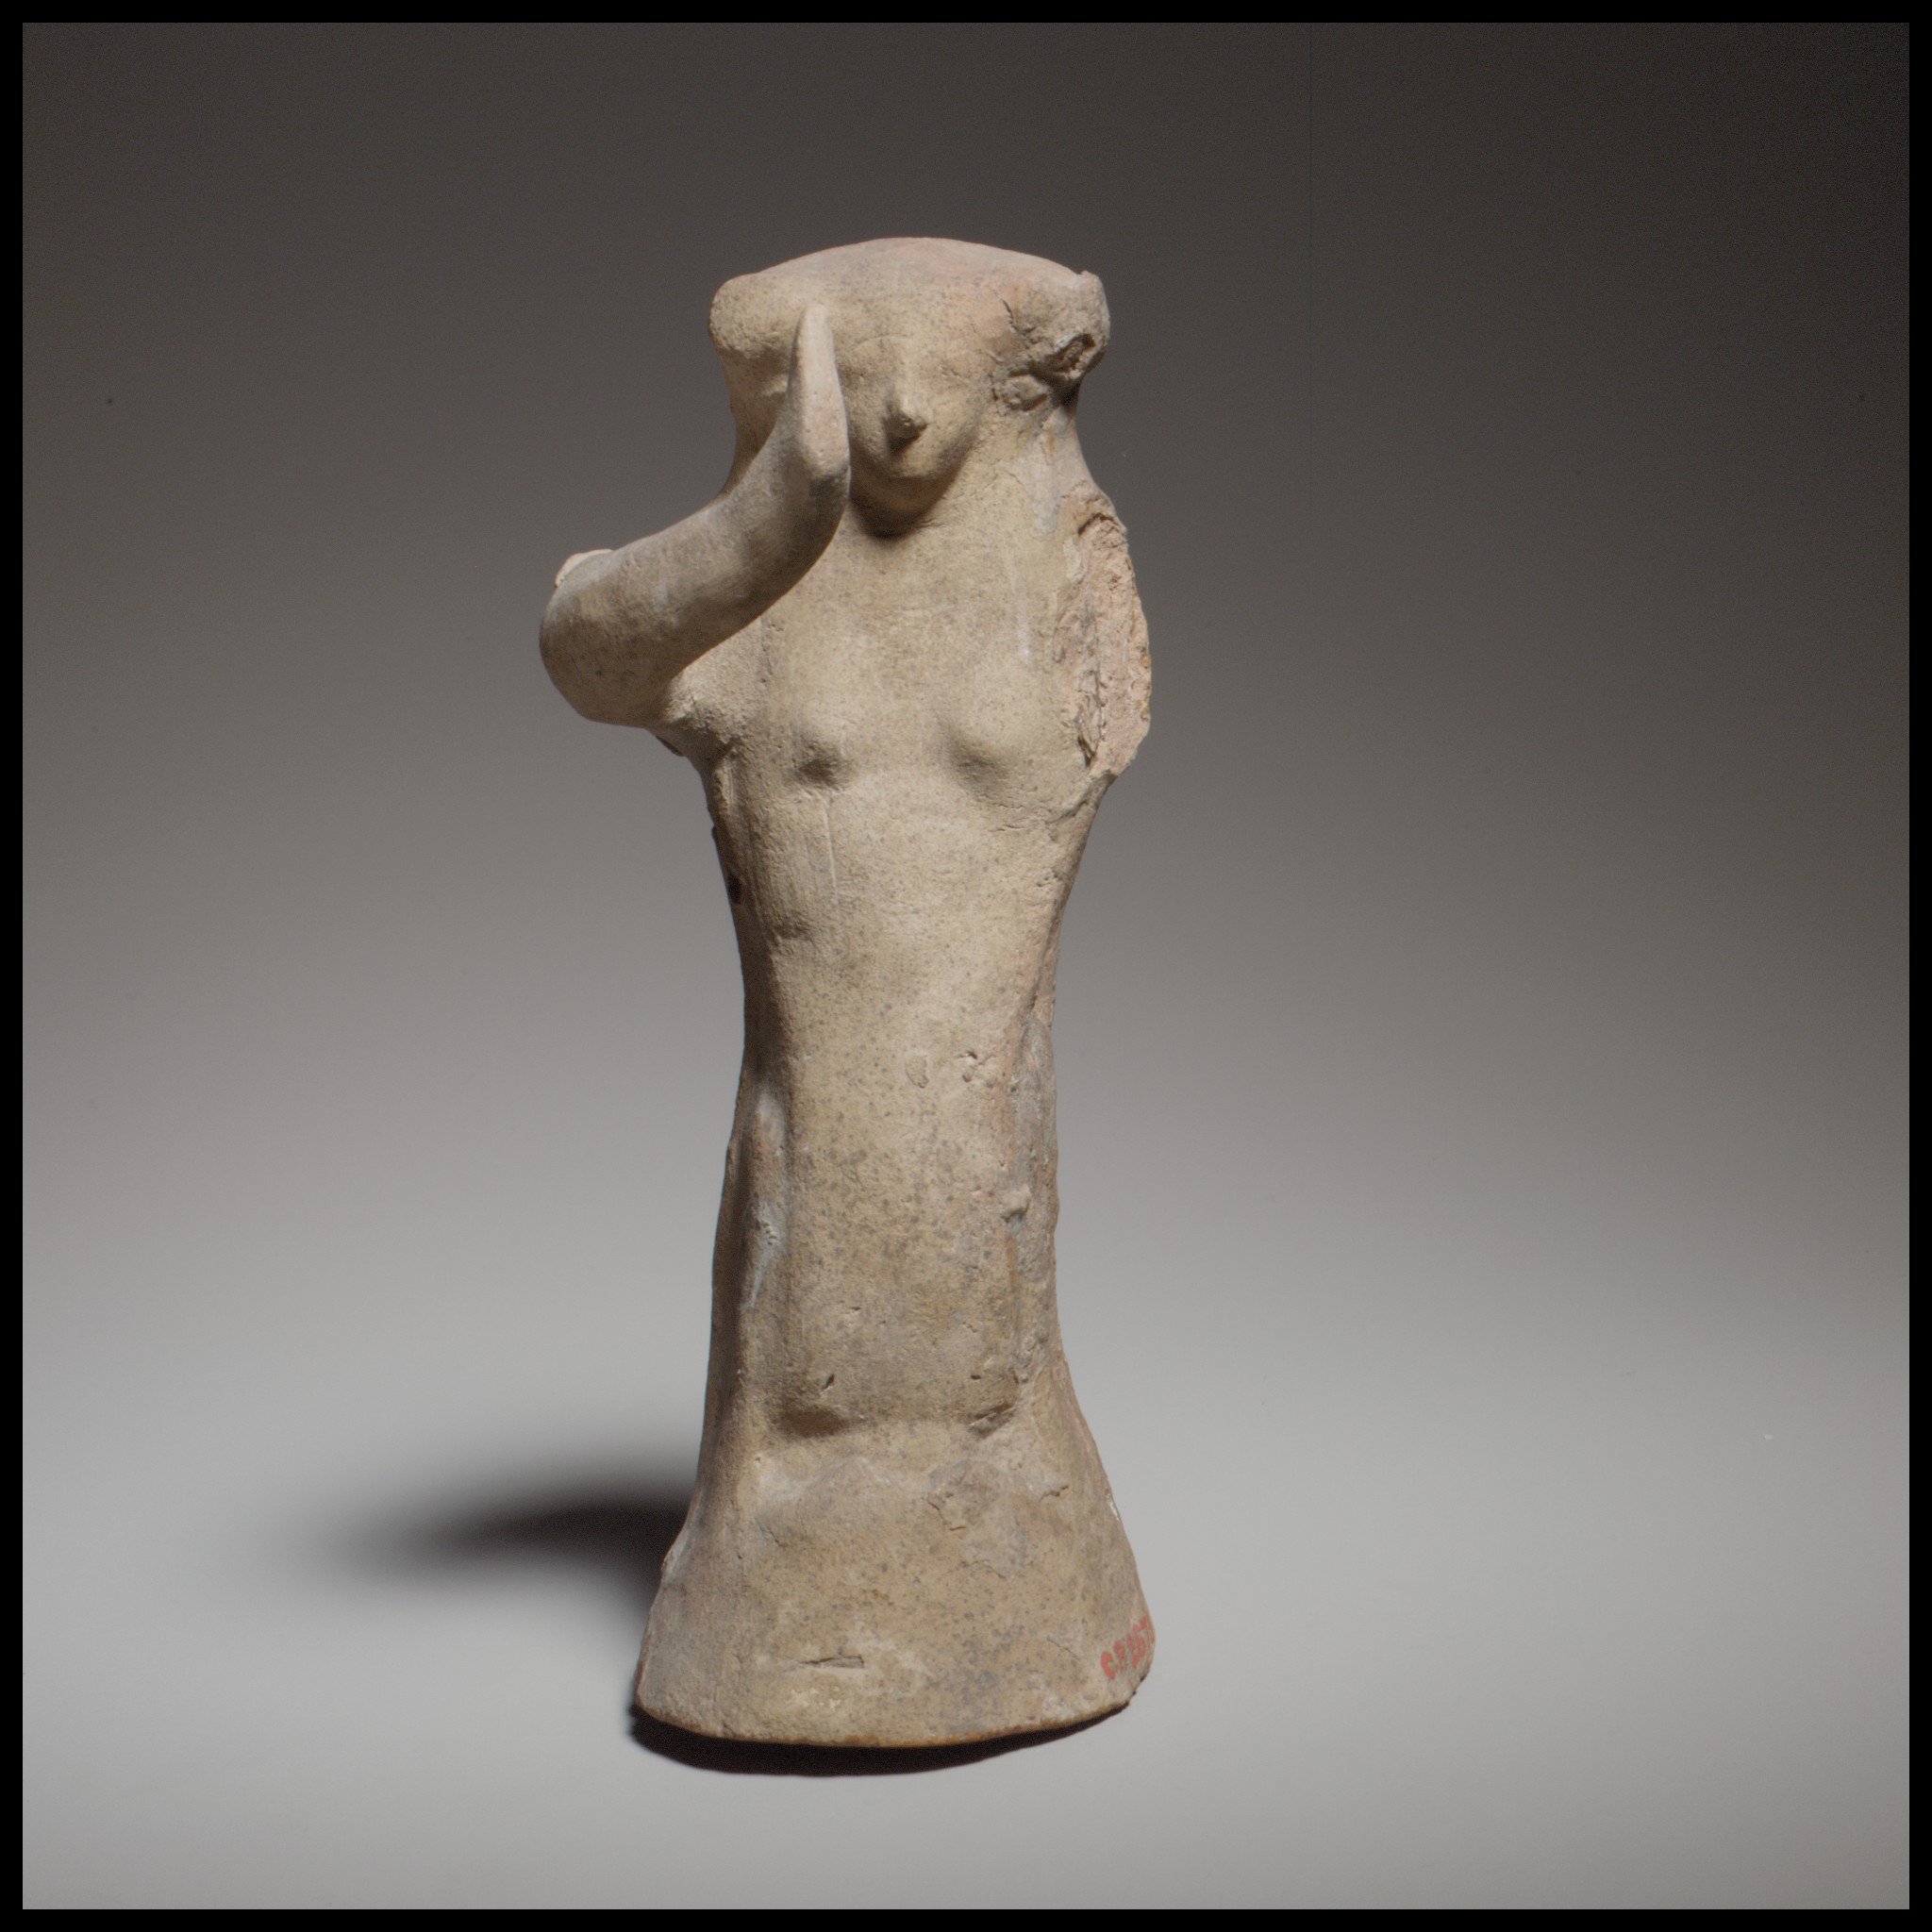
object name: statuette of a woman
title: Seated female figurine of the dea gravida type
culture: cypriot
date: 600-480 BCE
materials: terracotta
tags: women